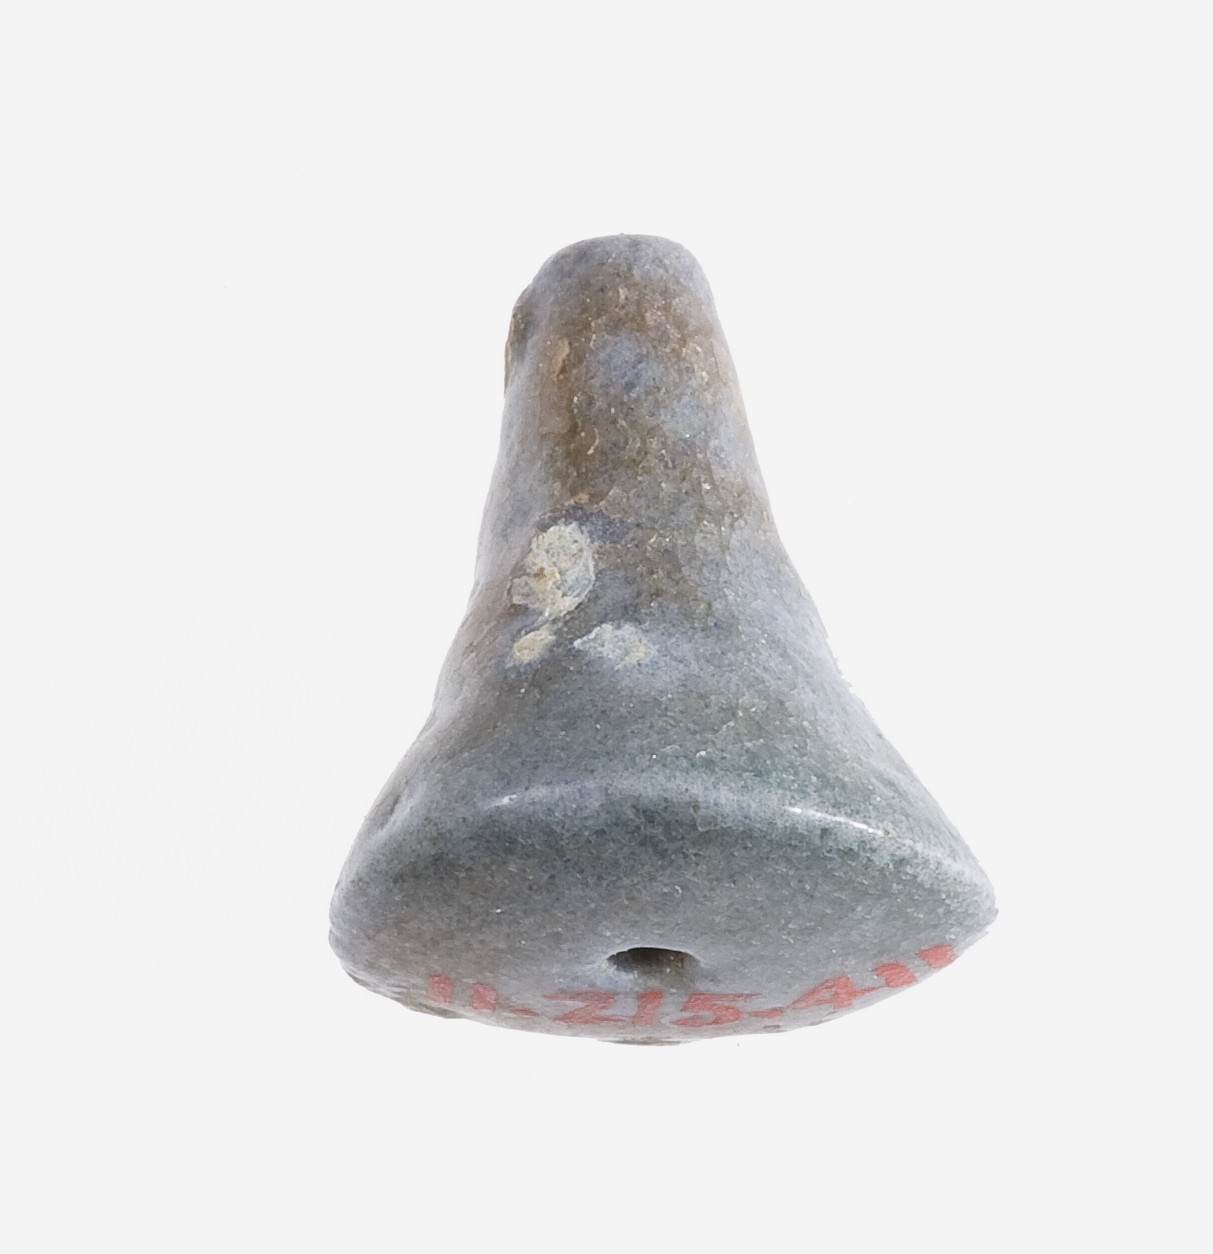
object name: pendant, umbel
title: Umbel Pendant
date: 1390-1352 BCE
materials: faience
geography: egypt